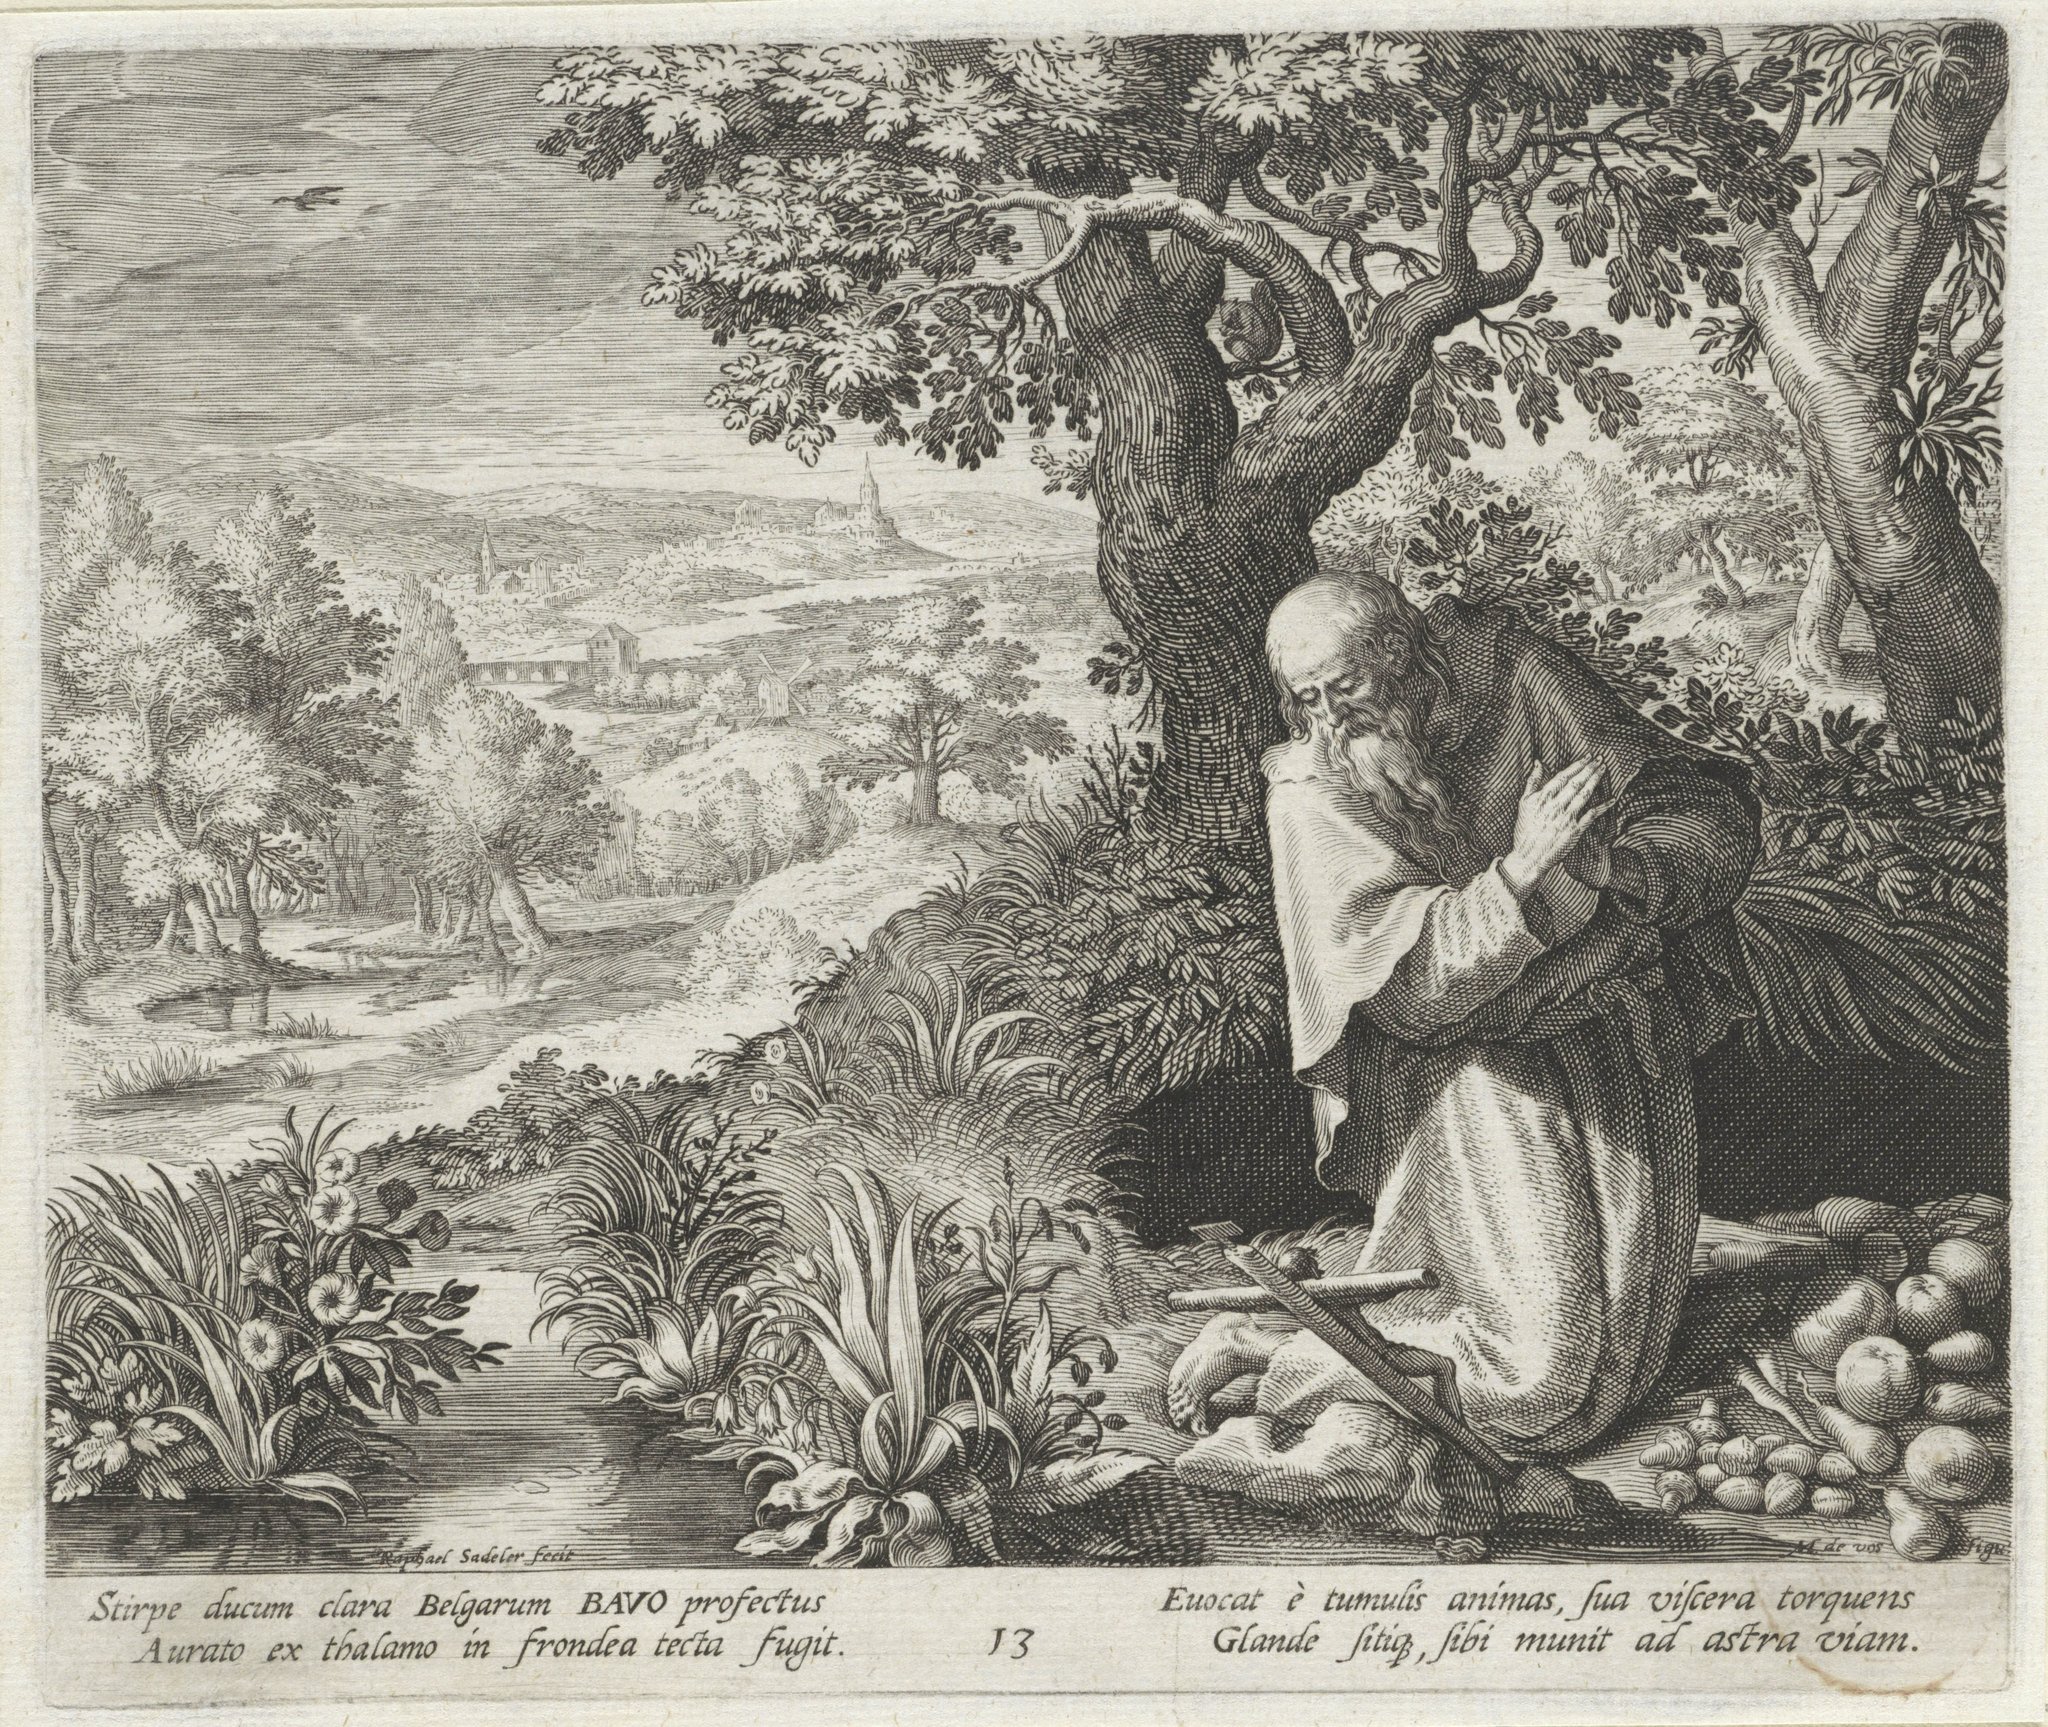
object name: print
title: Mannelijke kluizenaars en heremieten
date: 1594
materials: paper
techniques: engraving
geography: munich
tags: forest, wood, anchorite, hermit, the hermit bavo of ghent; possible attributes: falcon, hollow tree, purse, stone, sword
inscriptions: collector's mark: Lugt 240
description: Heilige Bavo van Gent, een vroeg-christelijke kluizenaar, zit geknield te bidden voor een crucifix. Achter hem een bosrijk landschap.